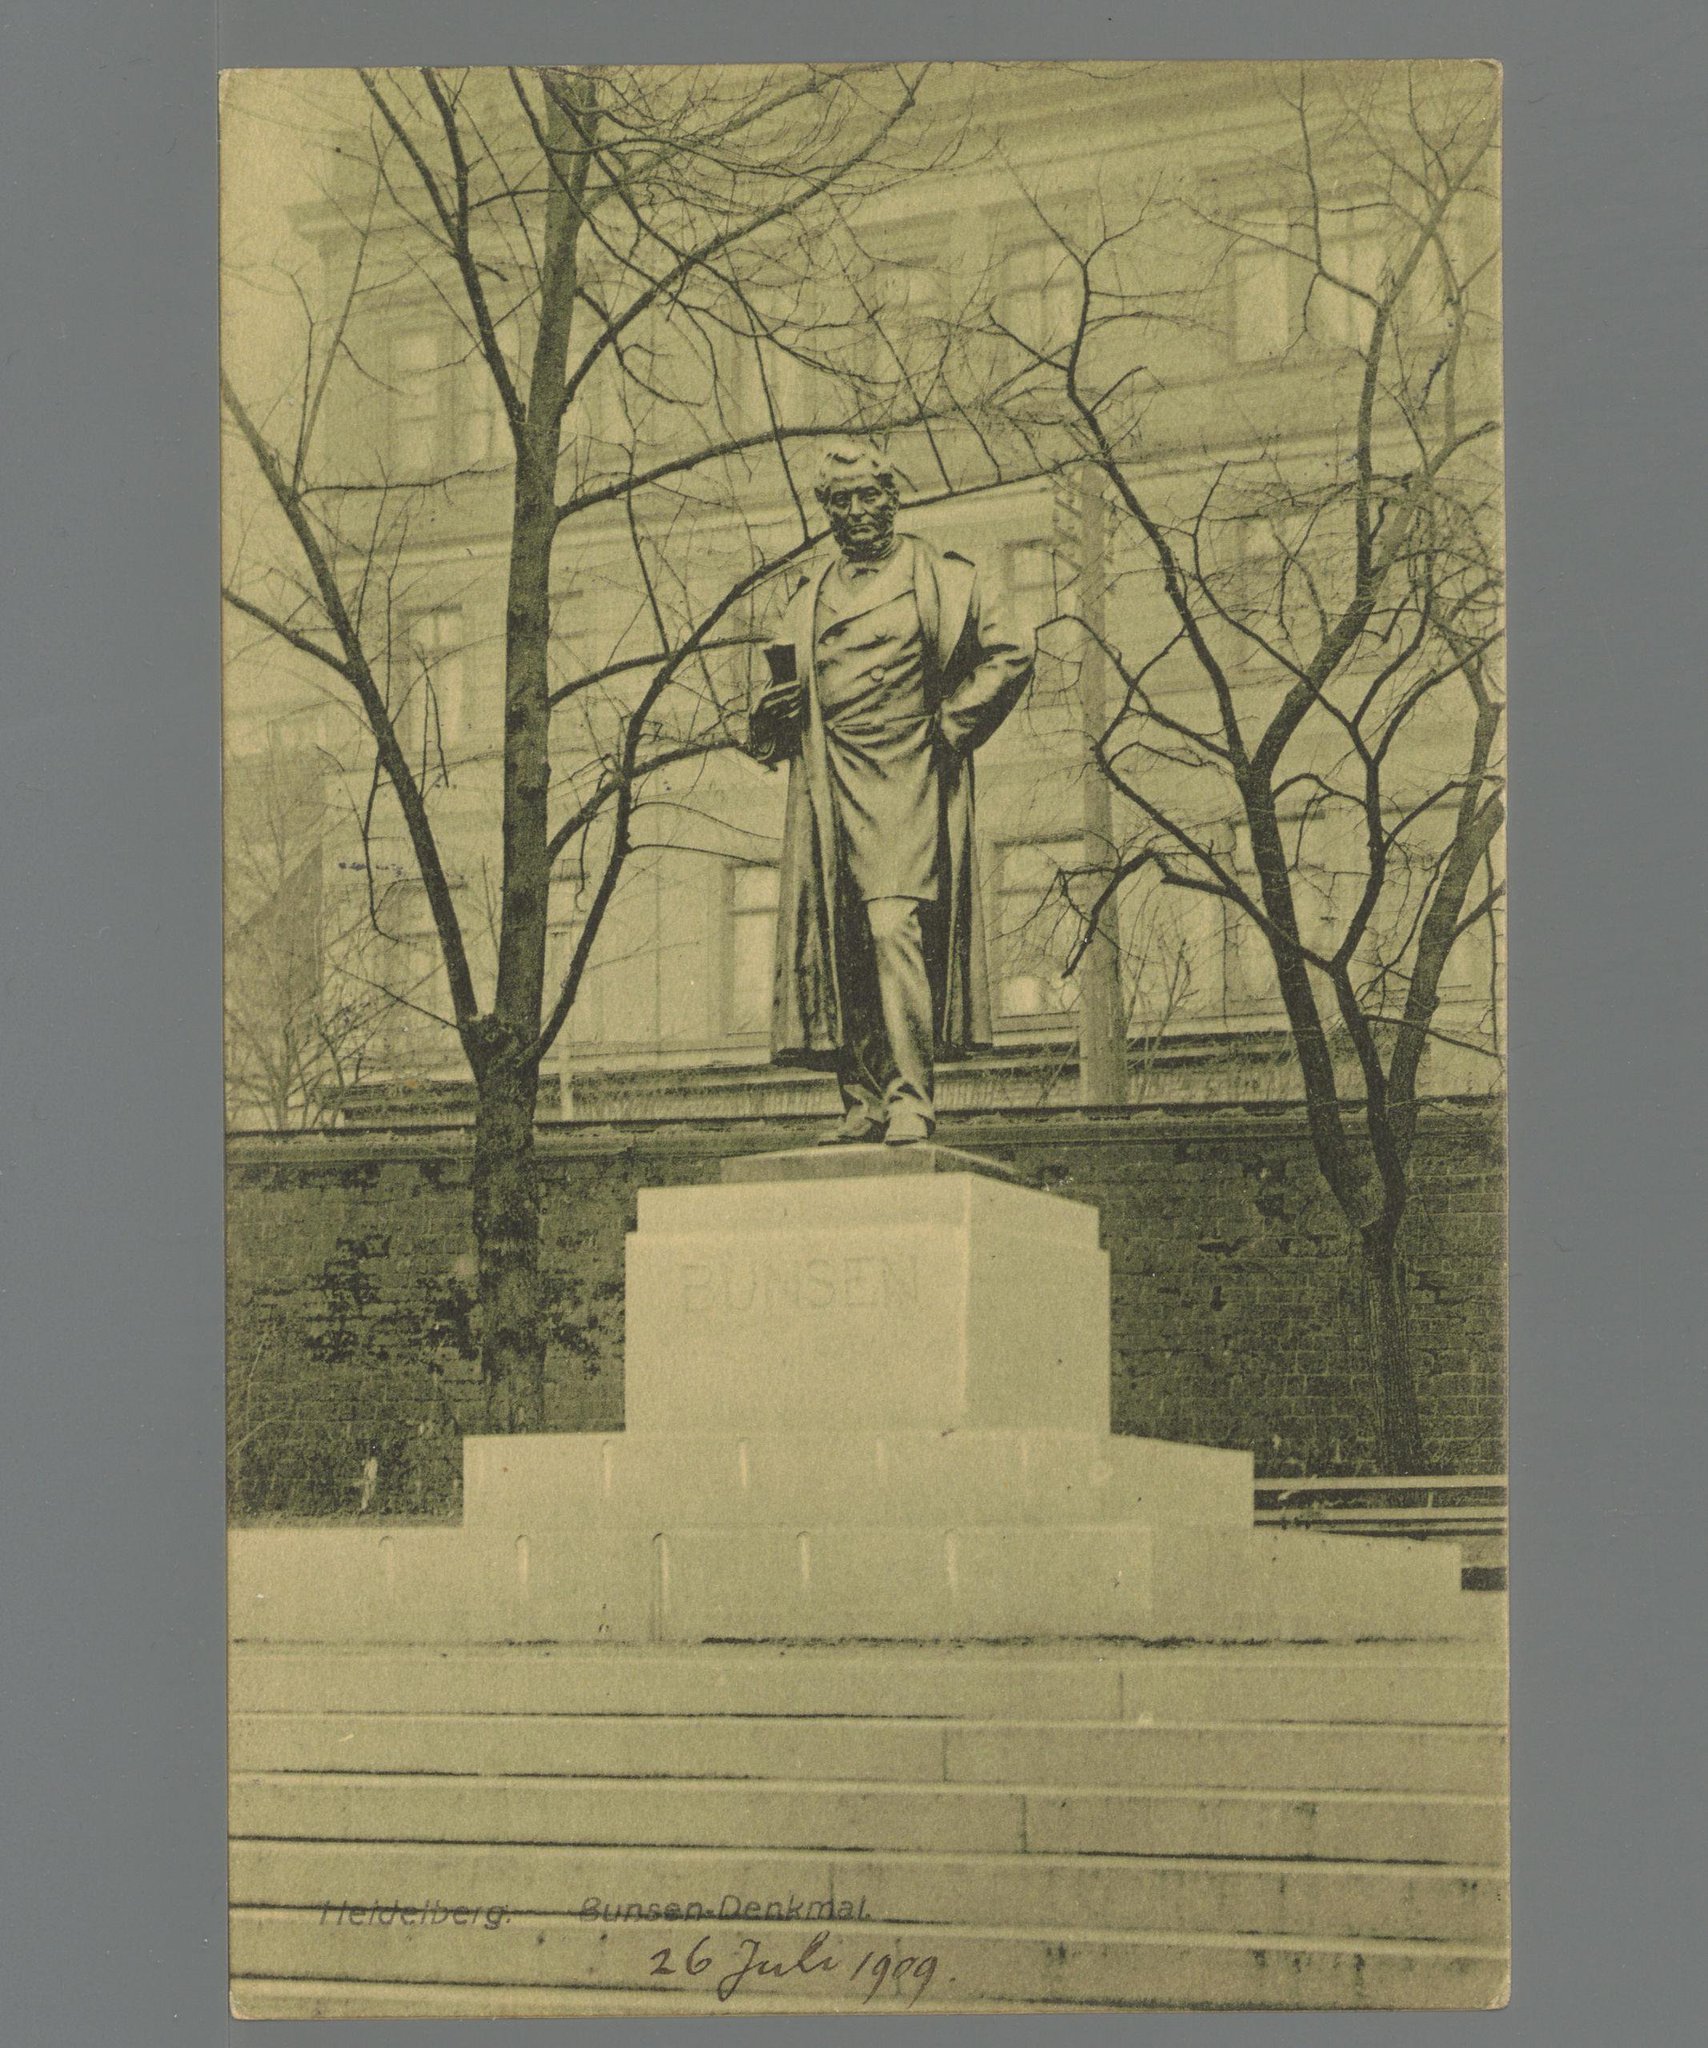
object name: ansichtkaart, prentbriefkaart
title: Heidelberg. Bunsen-Denkmal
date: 1909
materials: cardboard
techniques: photograph, writing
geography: heidelberg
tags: monument, statue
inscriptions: postage stamp